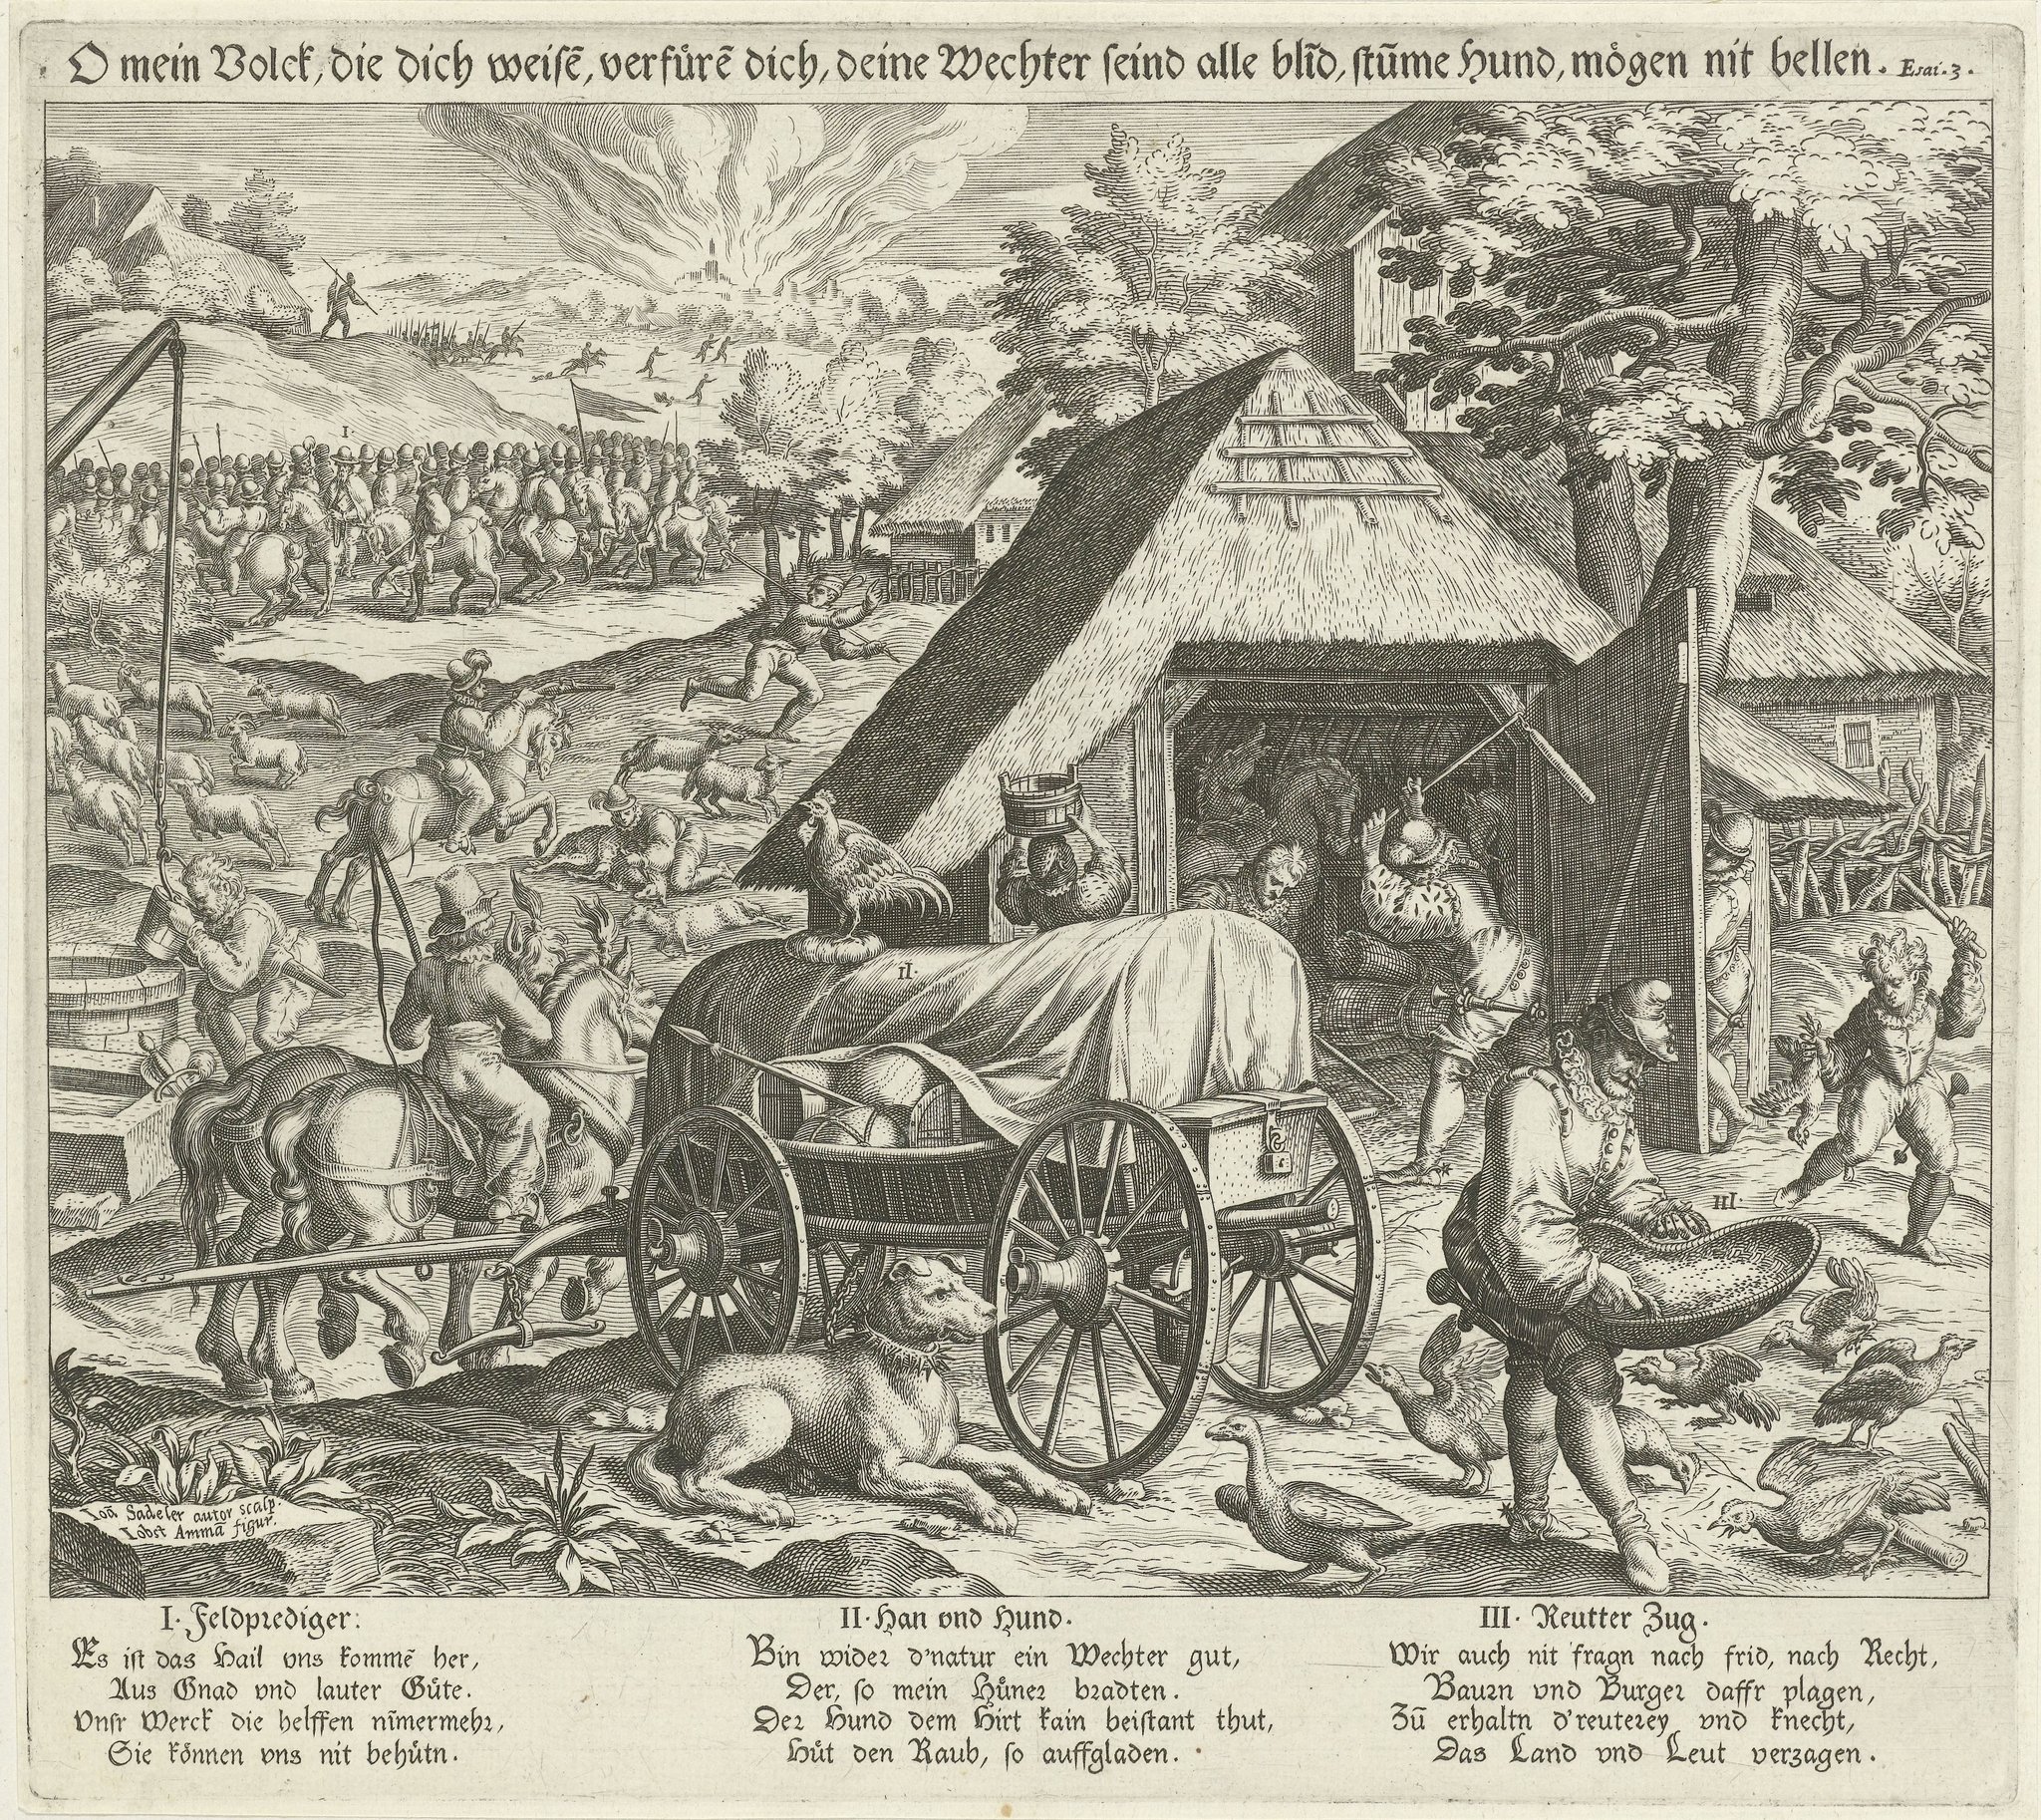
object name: print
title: Aanval op een boerderij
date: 1579-1595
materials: paper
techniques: engraving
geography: germany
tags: 'mundus inversus', the reversed world, the topsy-turvy world, 'le monde bestourné', watch-dog, dog watching, plundering ~ soldiers, fowl (cock, hen, chicken, etc.), the soldier; the soldier's life, booty, spoil, farm or solitary house in landscape, siege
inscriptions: collector's mark: Lugt 240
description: De prent bestaat uit drie aparte voorstellingen. Op de achtergrond staat een stad in brand en aanschouwt een heerser zijn legertroepen. Op het middenplan wordt een boerderij geplunderd, het vee gedood en de waterputten geledigd. Op de voorgrond bewaken een hond en een haan een kar met roversbuit in plaats de boerderij. Links op de voorgrond doen soldaten het werk van boeren: een soldaat strooit graan voor de kippen, een jonge schildknaap slacht een van de kippen en twee soldaten dorsen het koren. De prent heeft een Duits opschrift dat het volk waarschuwt voor slechte leiders. In de marge een onderschrift met drie Duitse teksten over de verschillende voorstellingen van deze omgekeerde wereld.